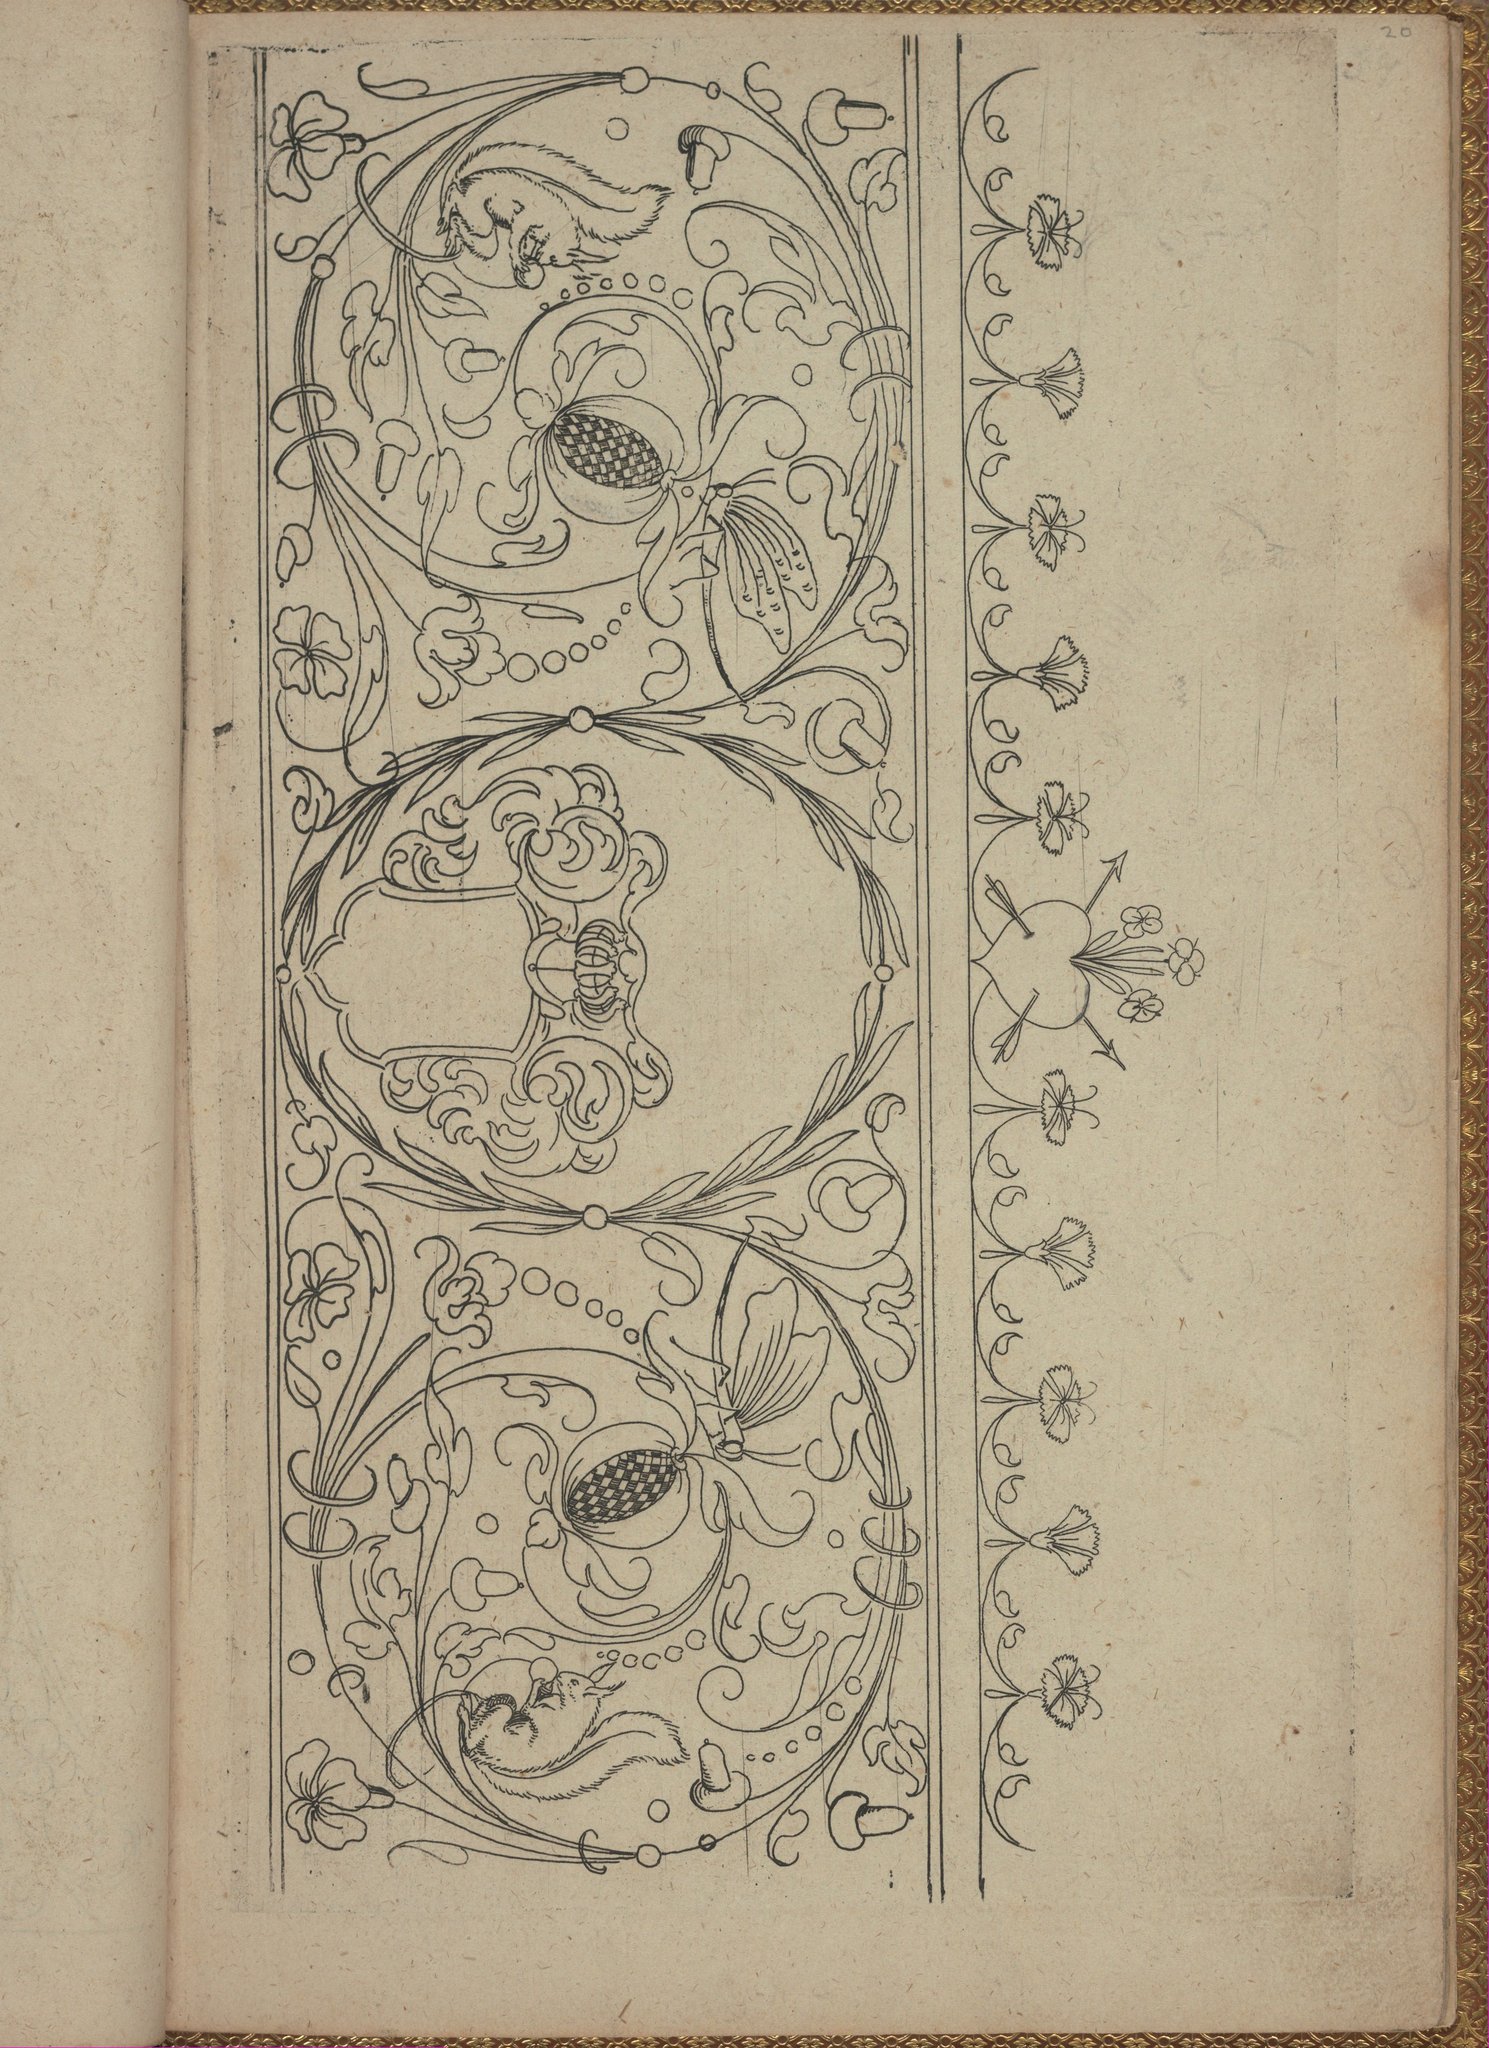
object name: book print ornament architecture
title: New Modelbüch (Page 20r)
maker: andreas bretschneider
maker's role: designer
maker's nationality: german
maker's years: 1573-1645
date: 1615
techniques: etching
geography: germany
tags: ornament